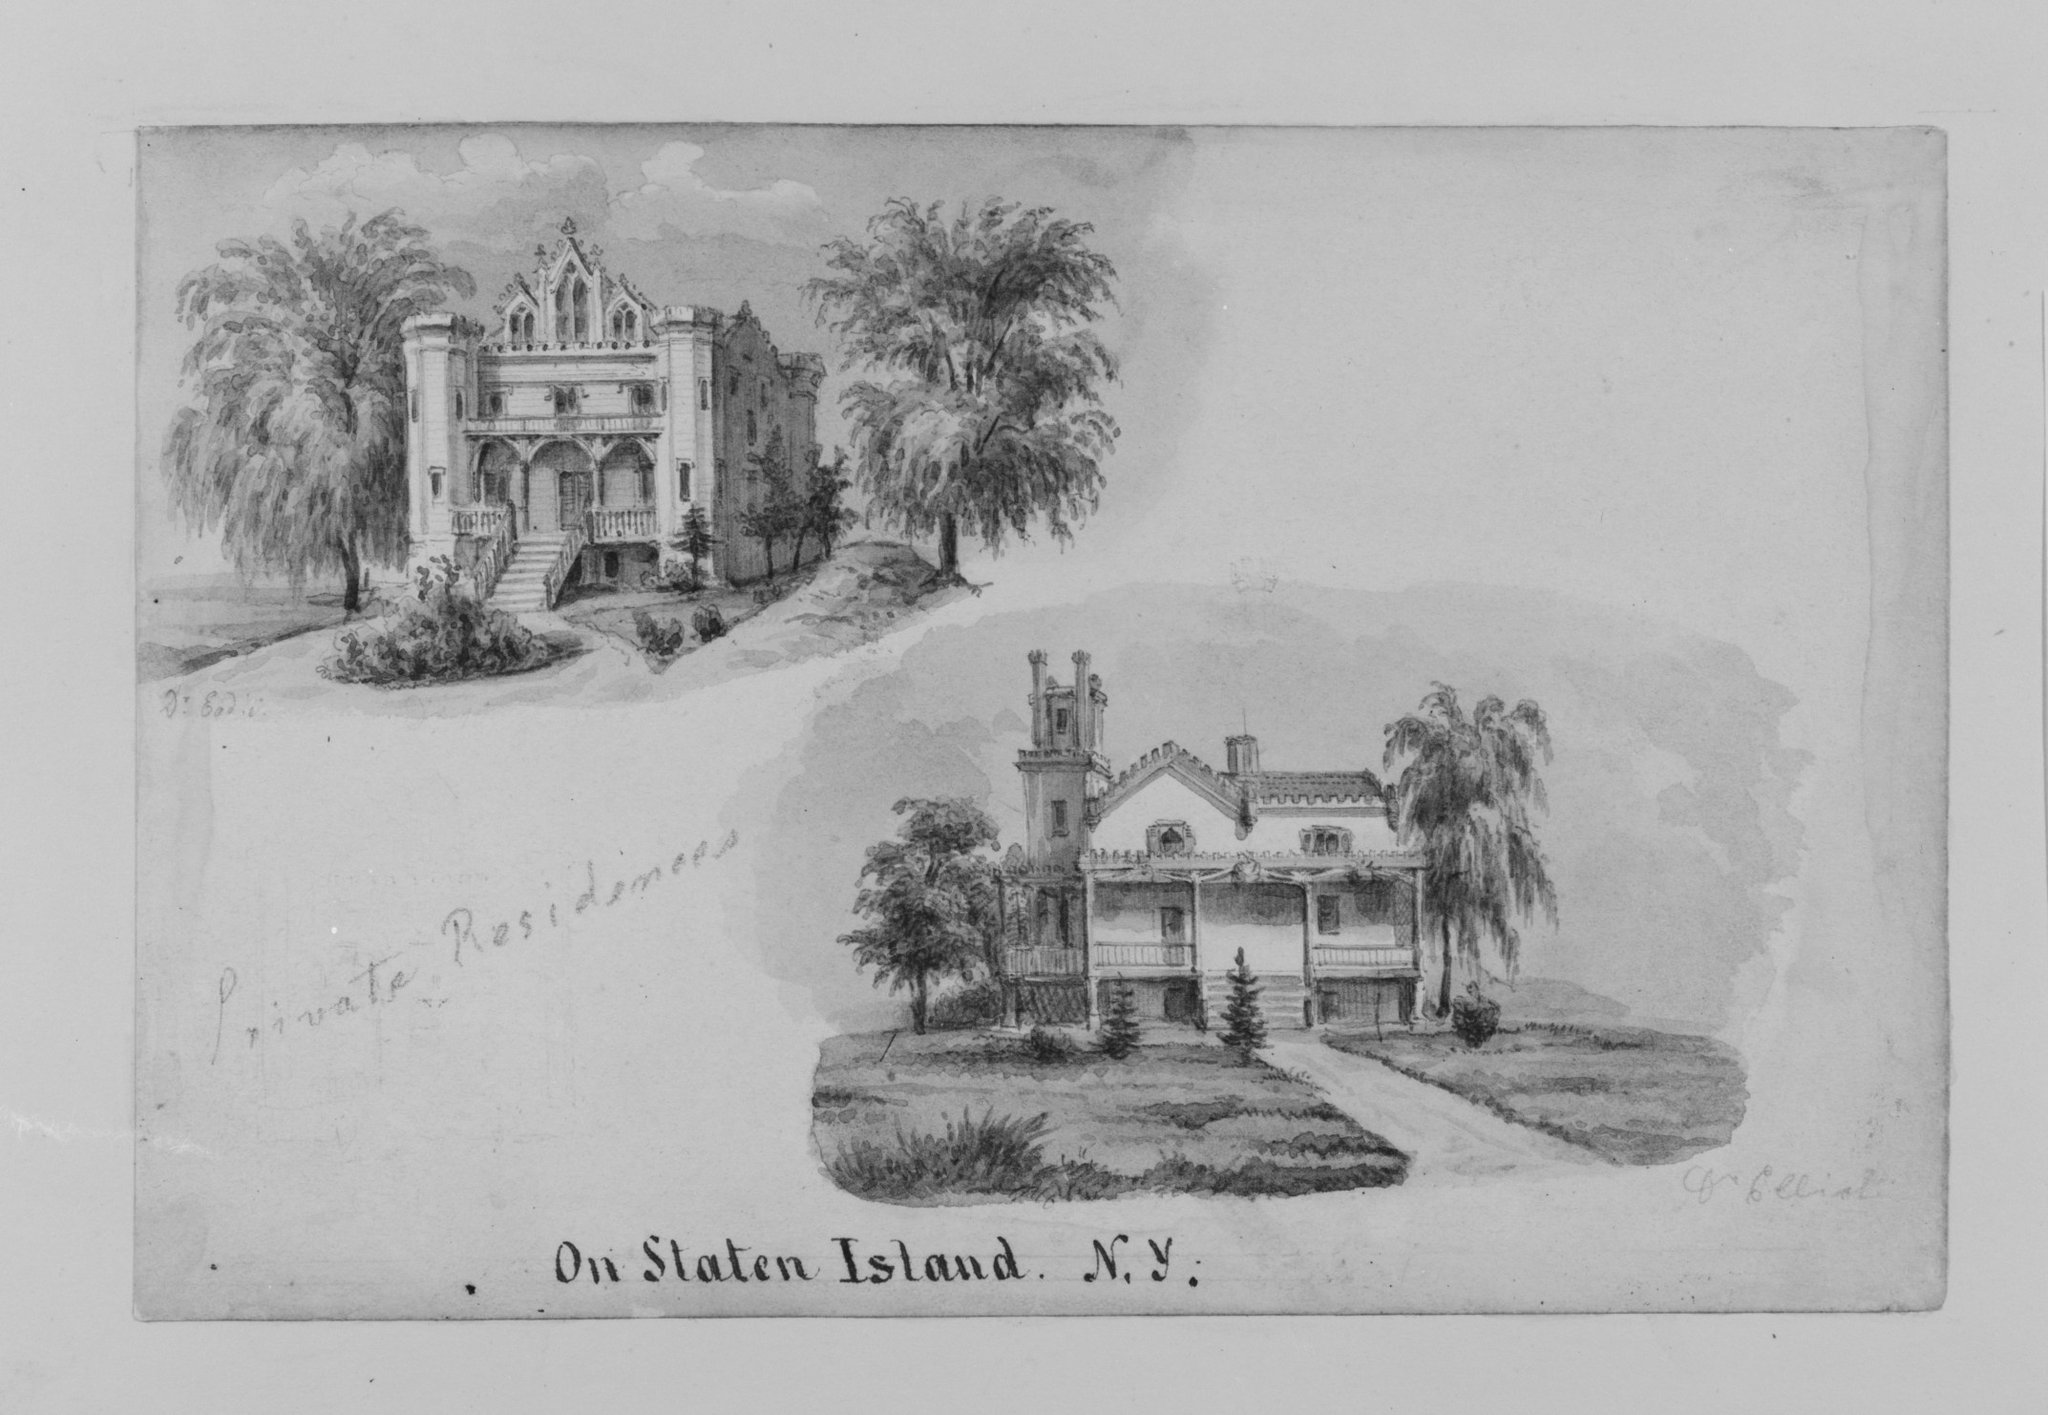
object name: drawing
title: Two Private Residence, Dr. Fadie Elliot, on Staten Island, New York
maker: augustus kollner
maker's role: artist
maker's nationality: american, born germany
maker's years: 1812-1906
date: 1872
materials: watercolor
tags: houses,new york city